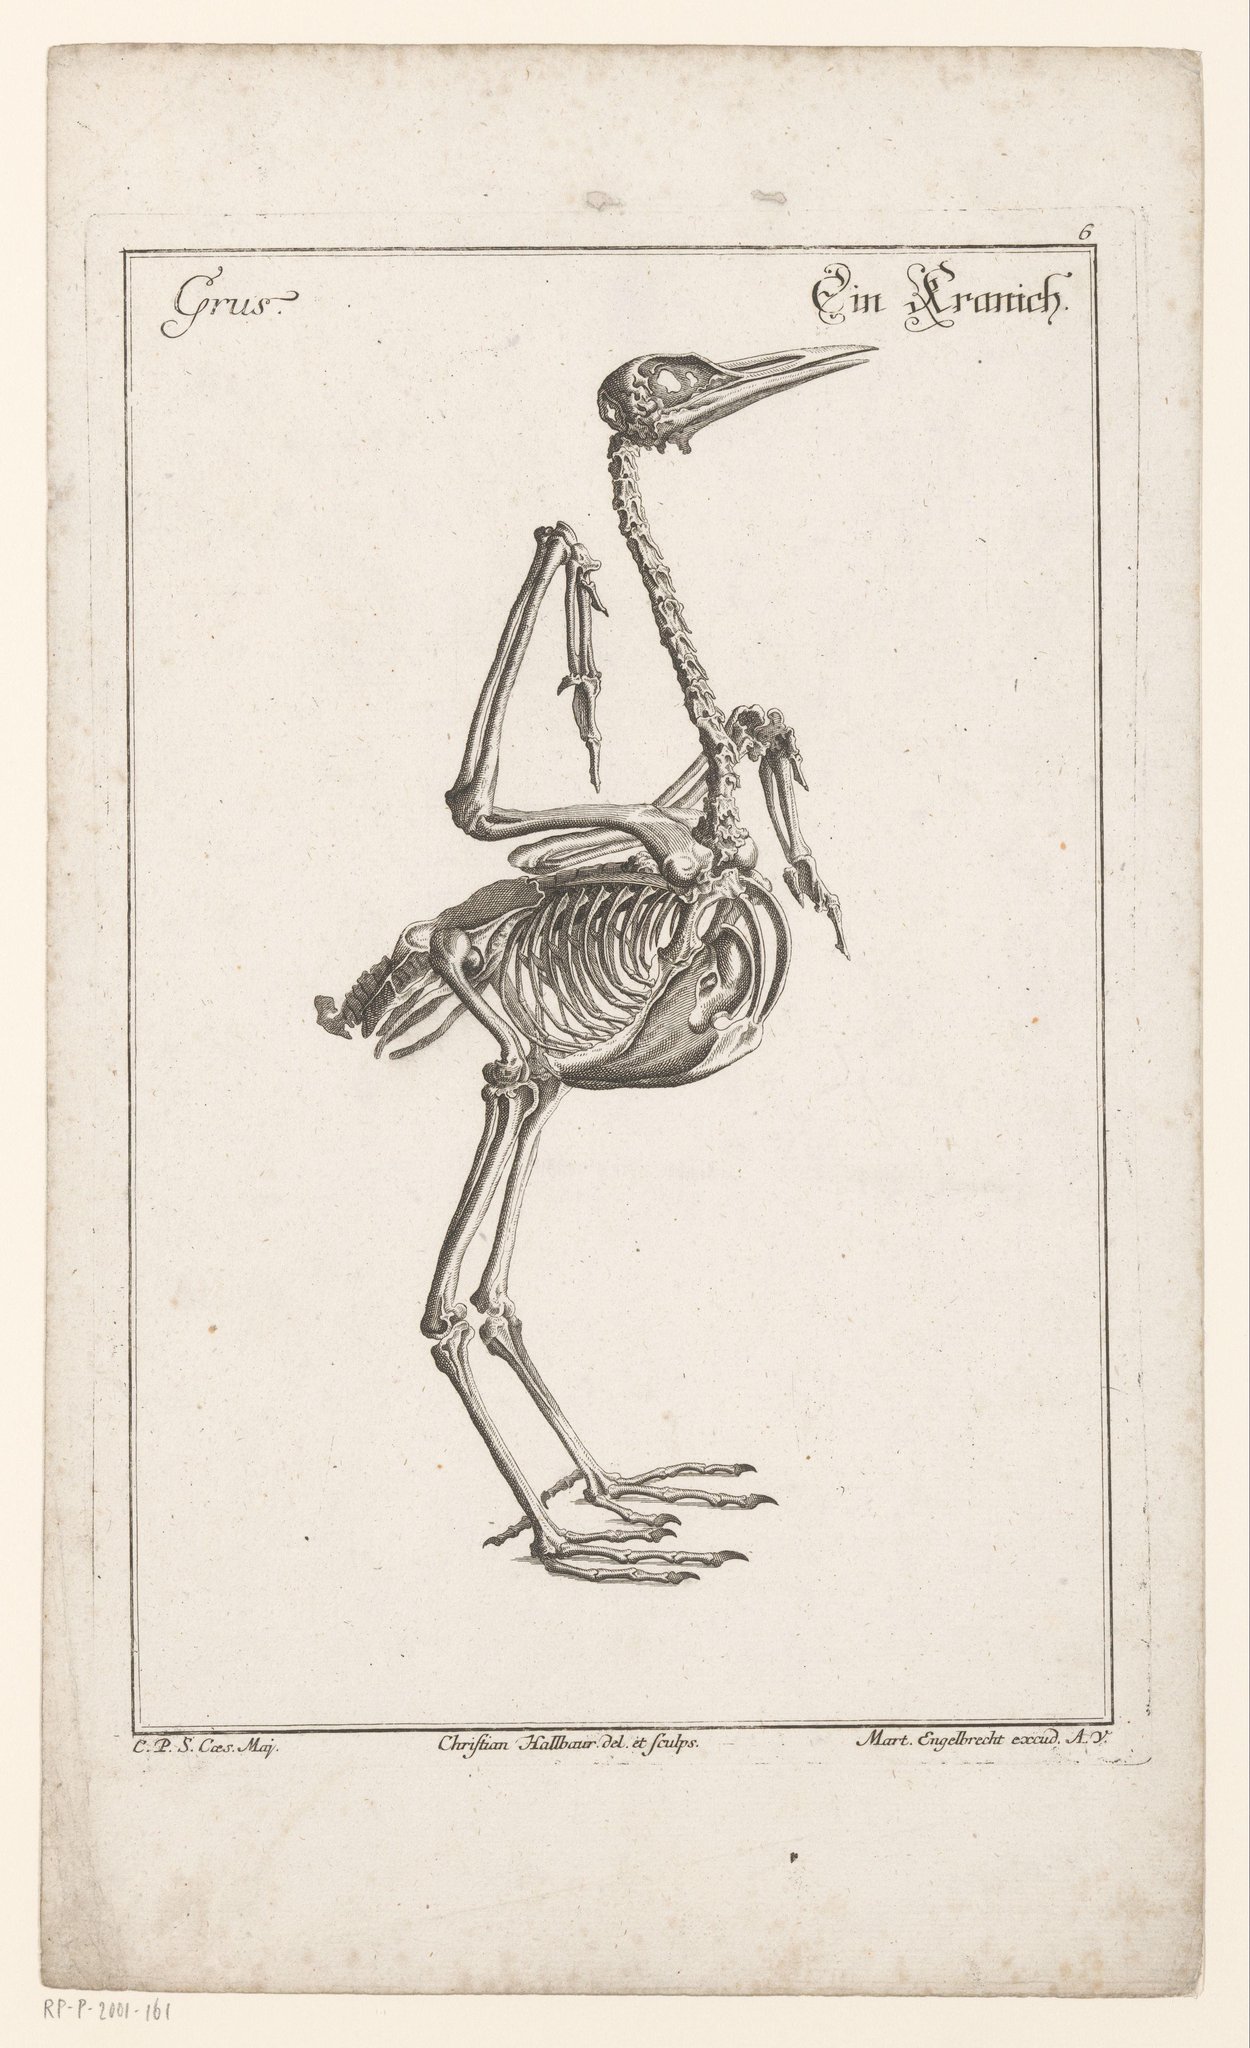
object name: print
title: Unterschiedliche Sceleta oder Bein-Cörper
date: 1735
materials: paper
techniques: etching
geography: augsburg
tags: shore-birds and wading-birds: crane (+ skeleton of an animal)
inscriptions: collector's mark: Lugt 2760, collector's mark: Lugt 2228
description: Prent gebruikt voor: Hallbaur, Christian. Unterschiedliche Sceleta oder Bein-Cörper. Augsburg: s.n., 1735.